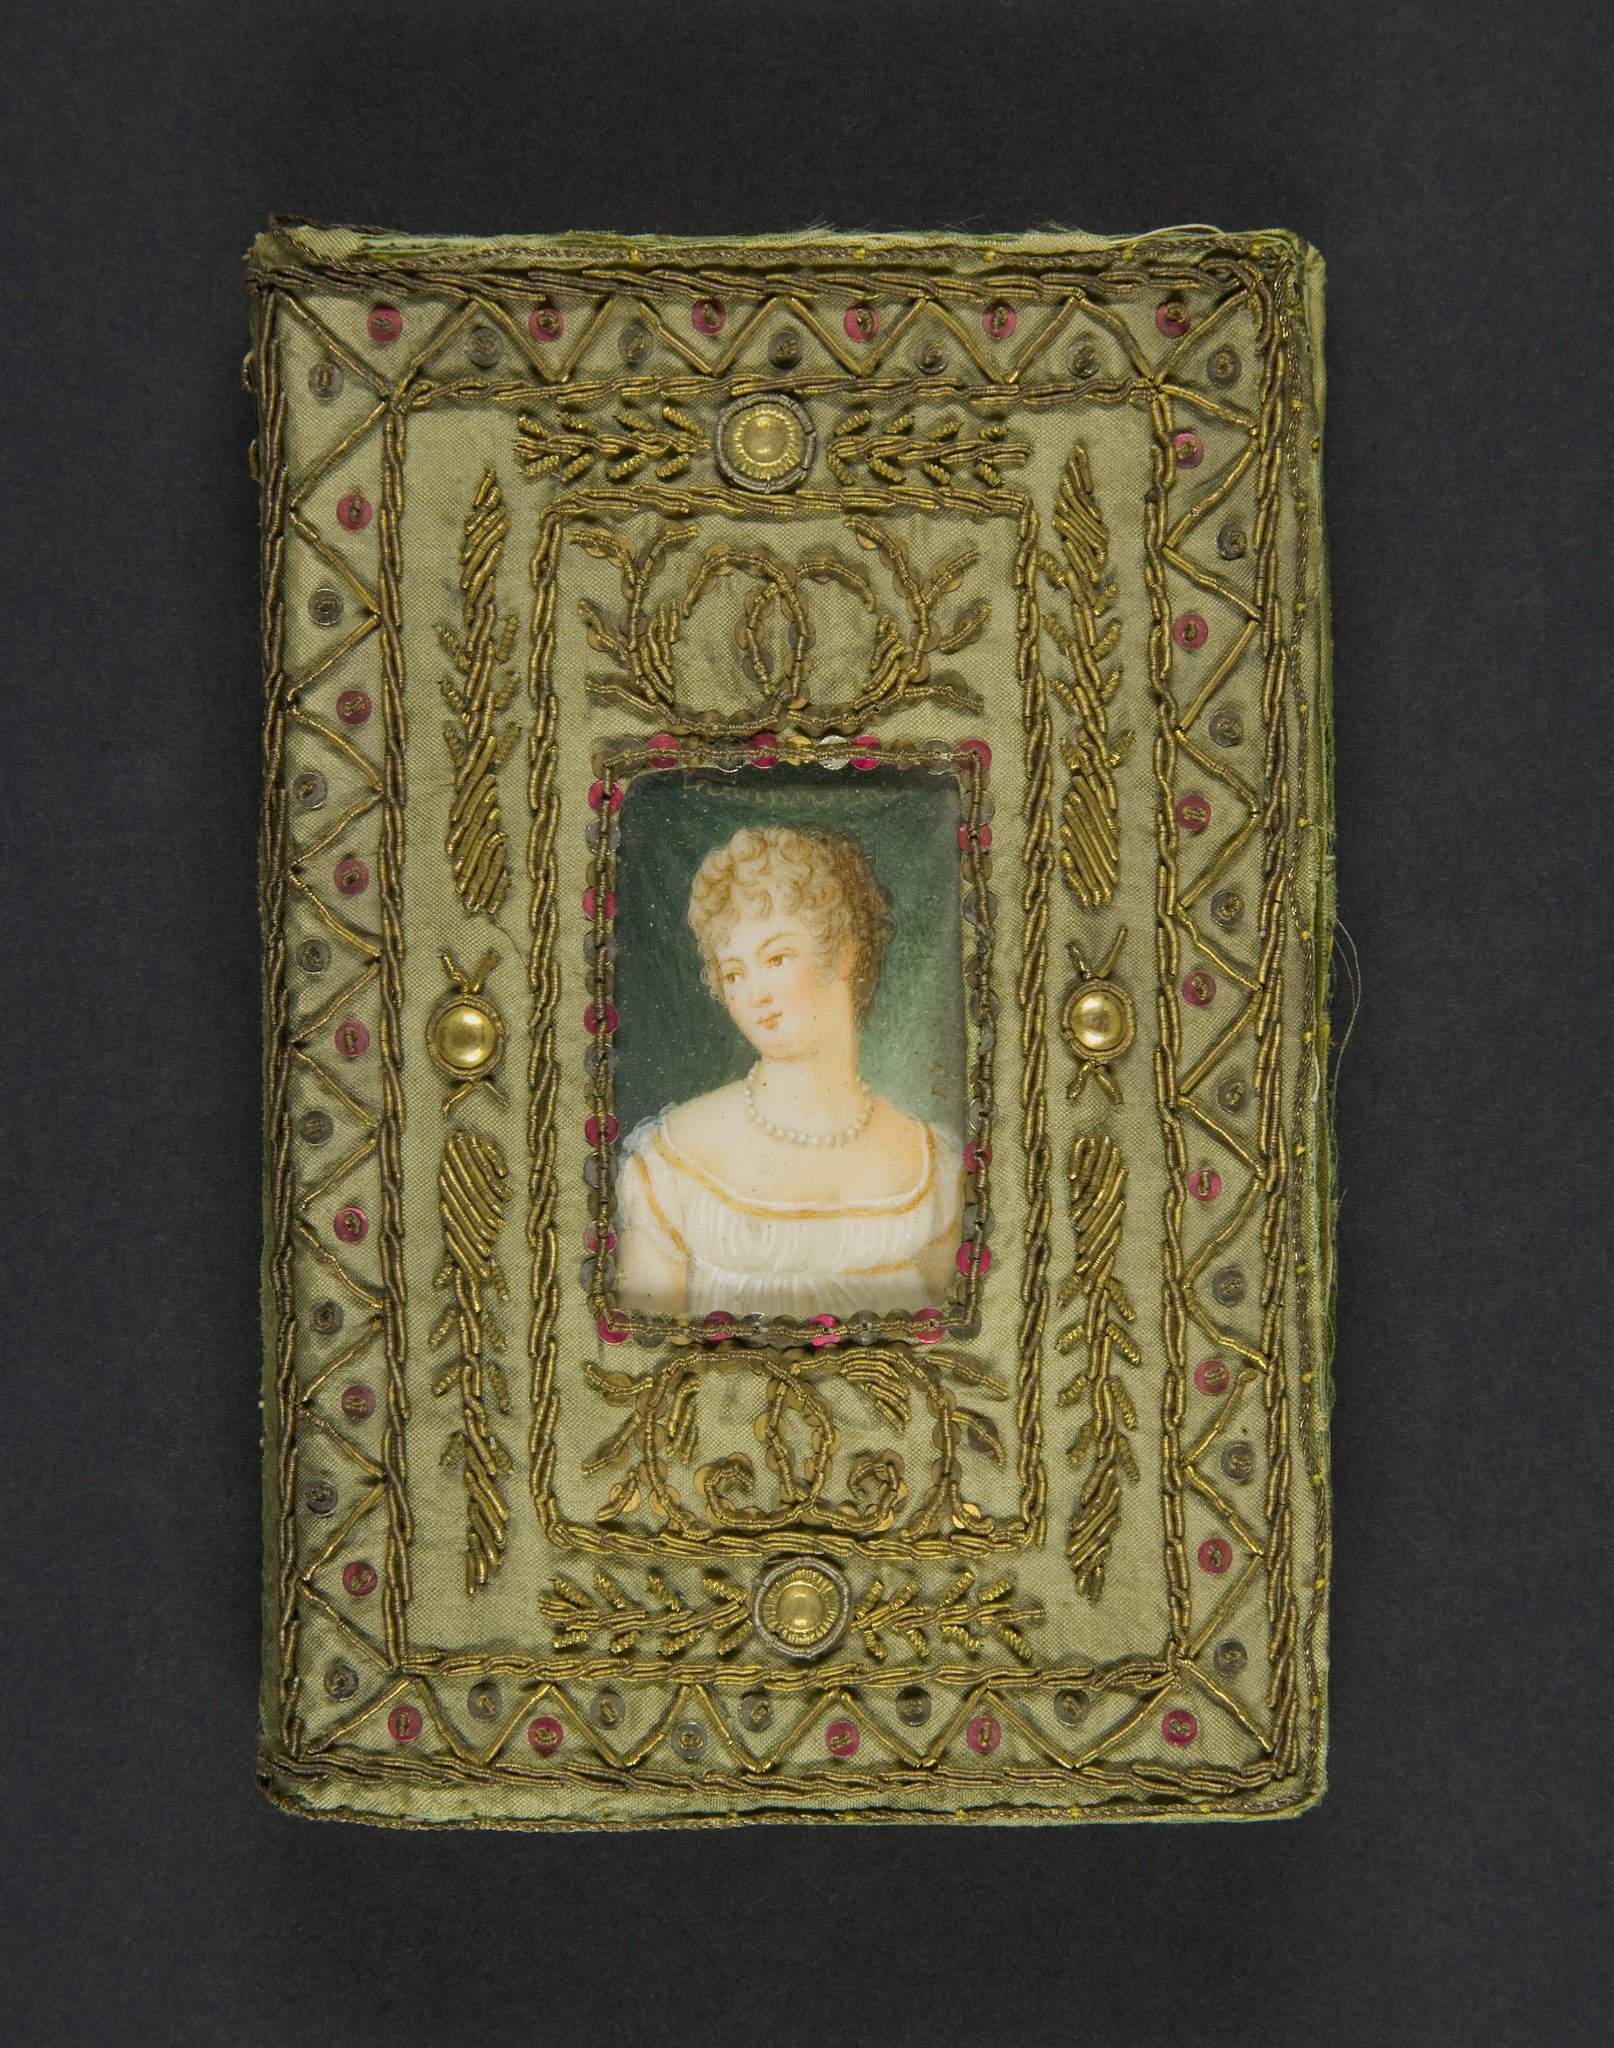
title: L'ami des voyageurs, ou, Etrennes instructives, curieuses et nécessaires à toutes les personnes qui voyagent, soit à pied, à cheval, en voiture, ou par eau : soit par les voitures publiques, etc. etc.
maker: marcilly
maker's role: publisher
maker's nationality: french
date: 1820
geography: france